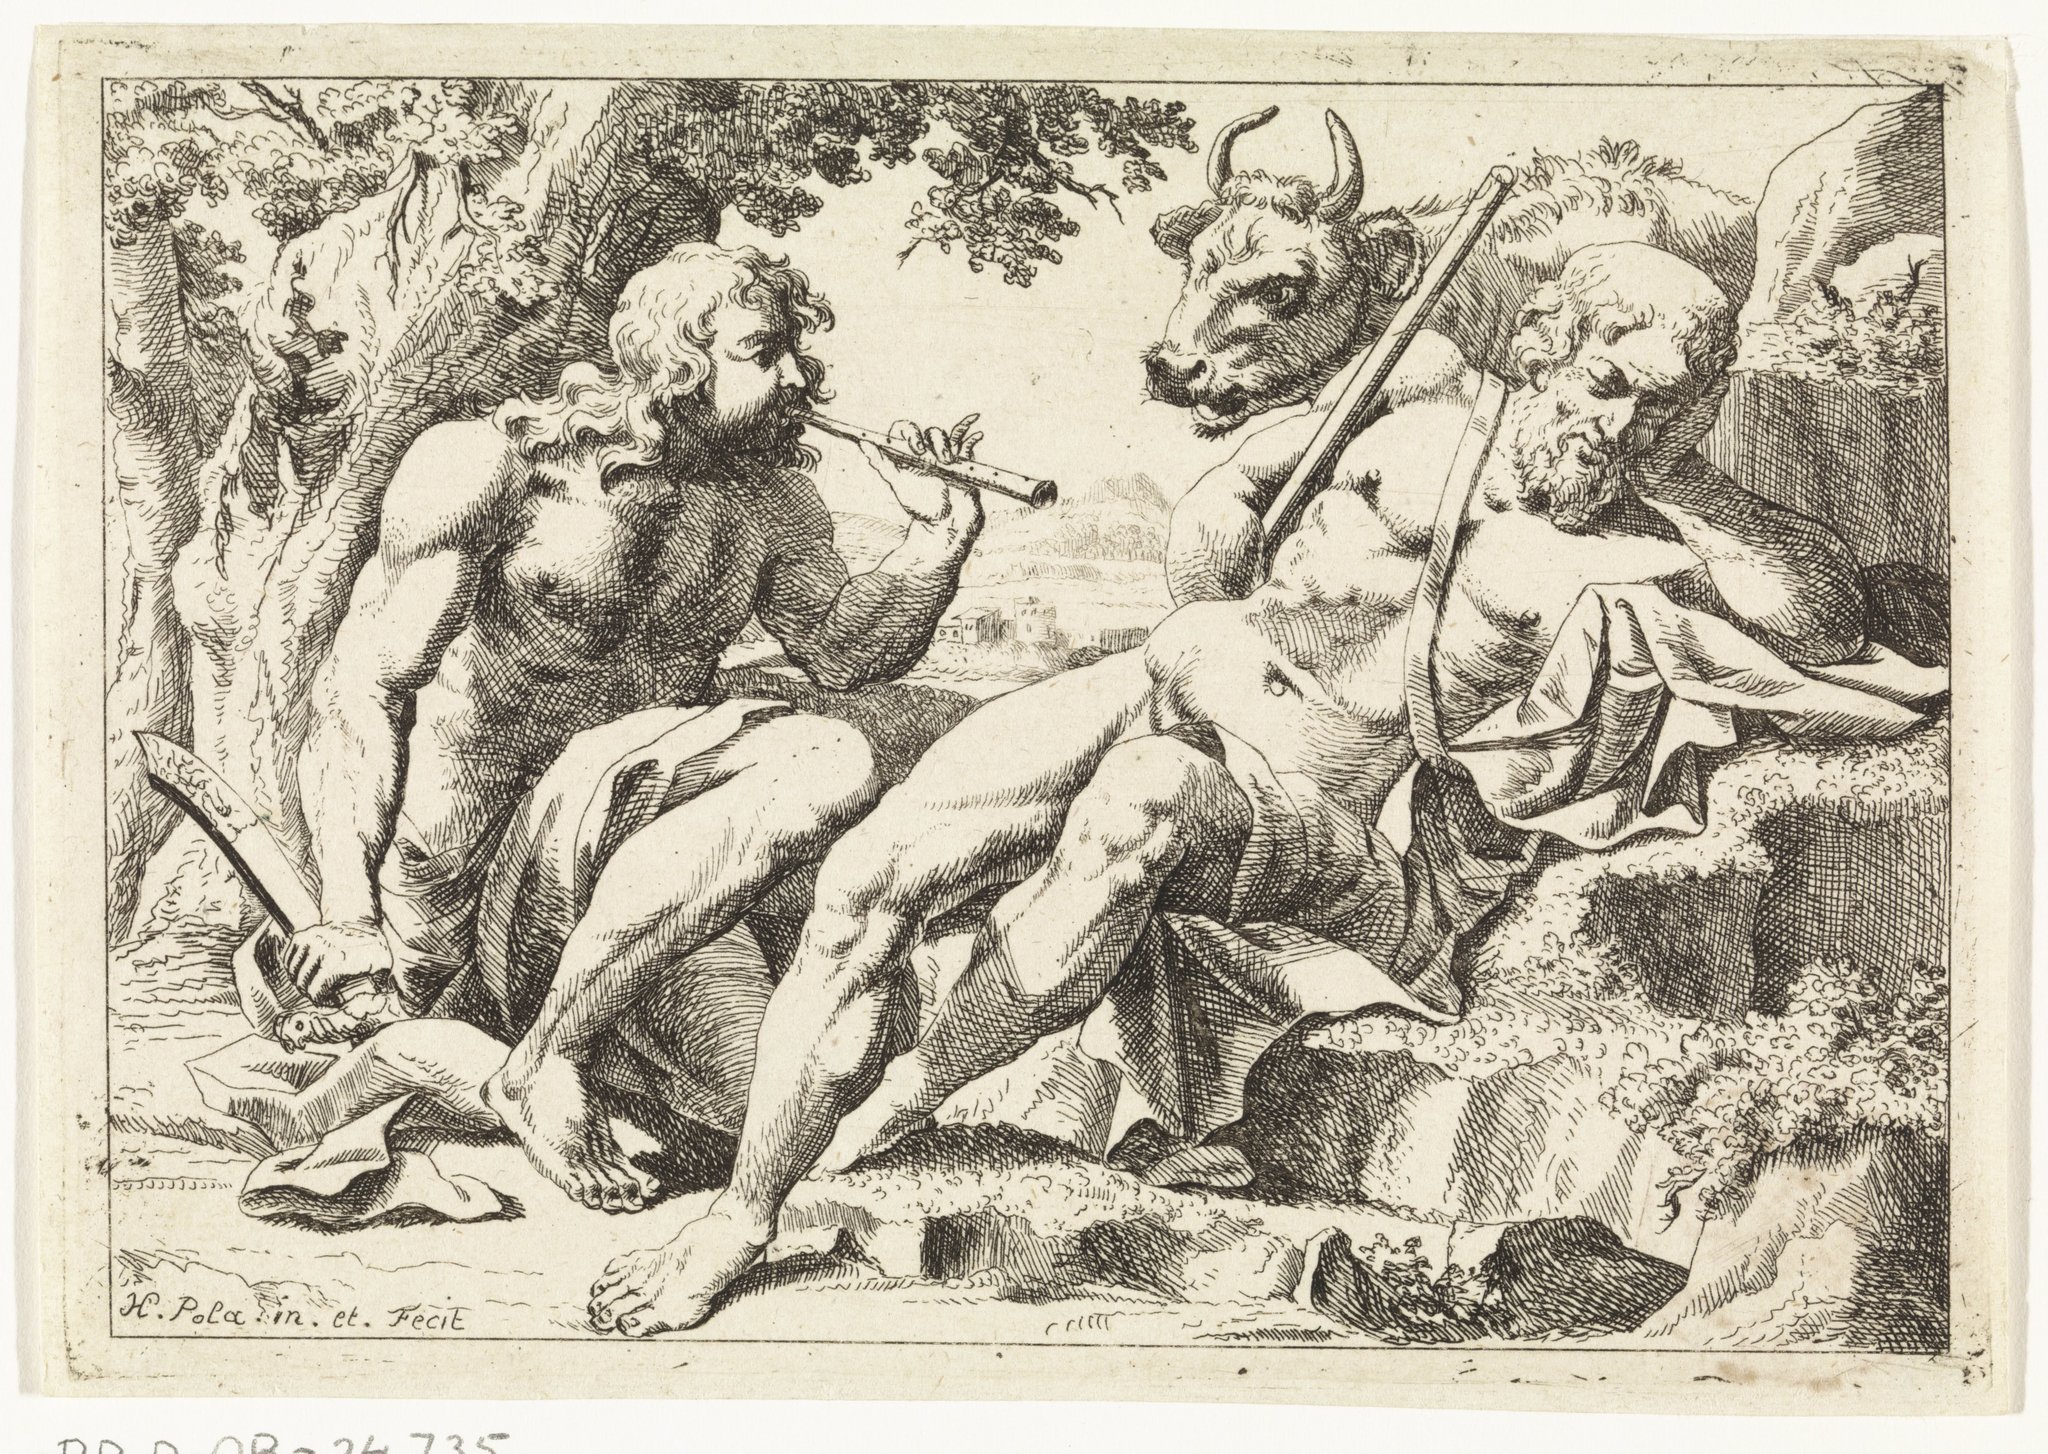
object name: print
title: Mercurius speelt Argus in slaap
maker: hendrik pola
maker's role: draughtsman, painter, print maker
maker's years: 1676-1748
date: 1705-1713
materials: paper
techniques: engraving, etching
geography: the hague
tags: mercury lulls argus into sleep by making music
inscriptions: collector's mark: Lugt 240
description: Mercurius bespeelt zijn fluit voor de slapende Argus. In zijn andere hand houdt hij een zwaard. Achter Argus staat de koe Io.